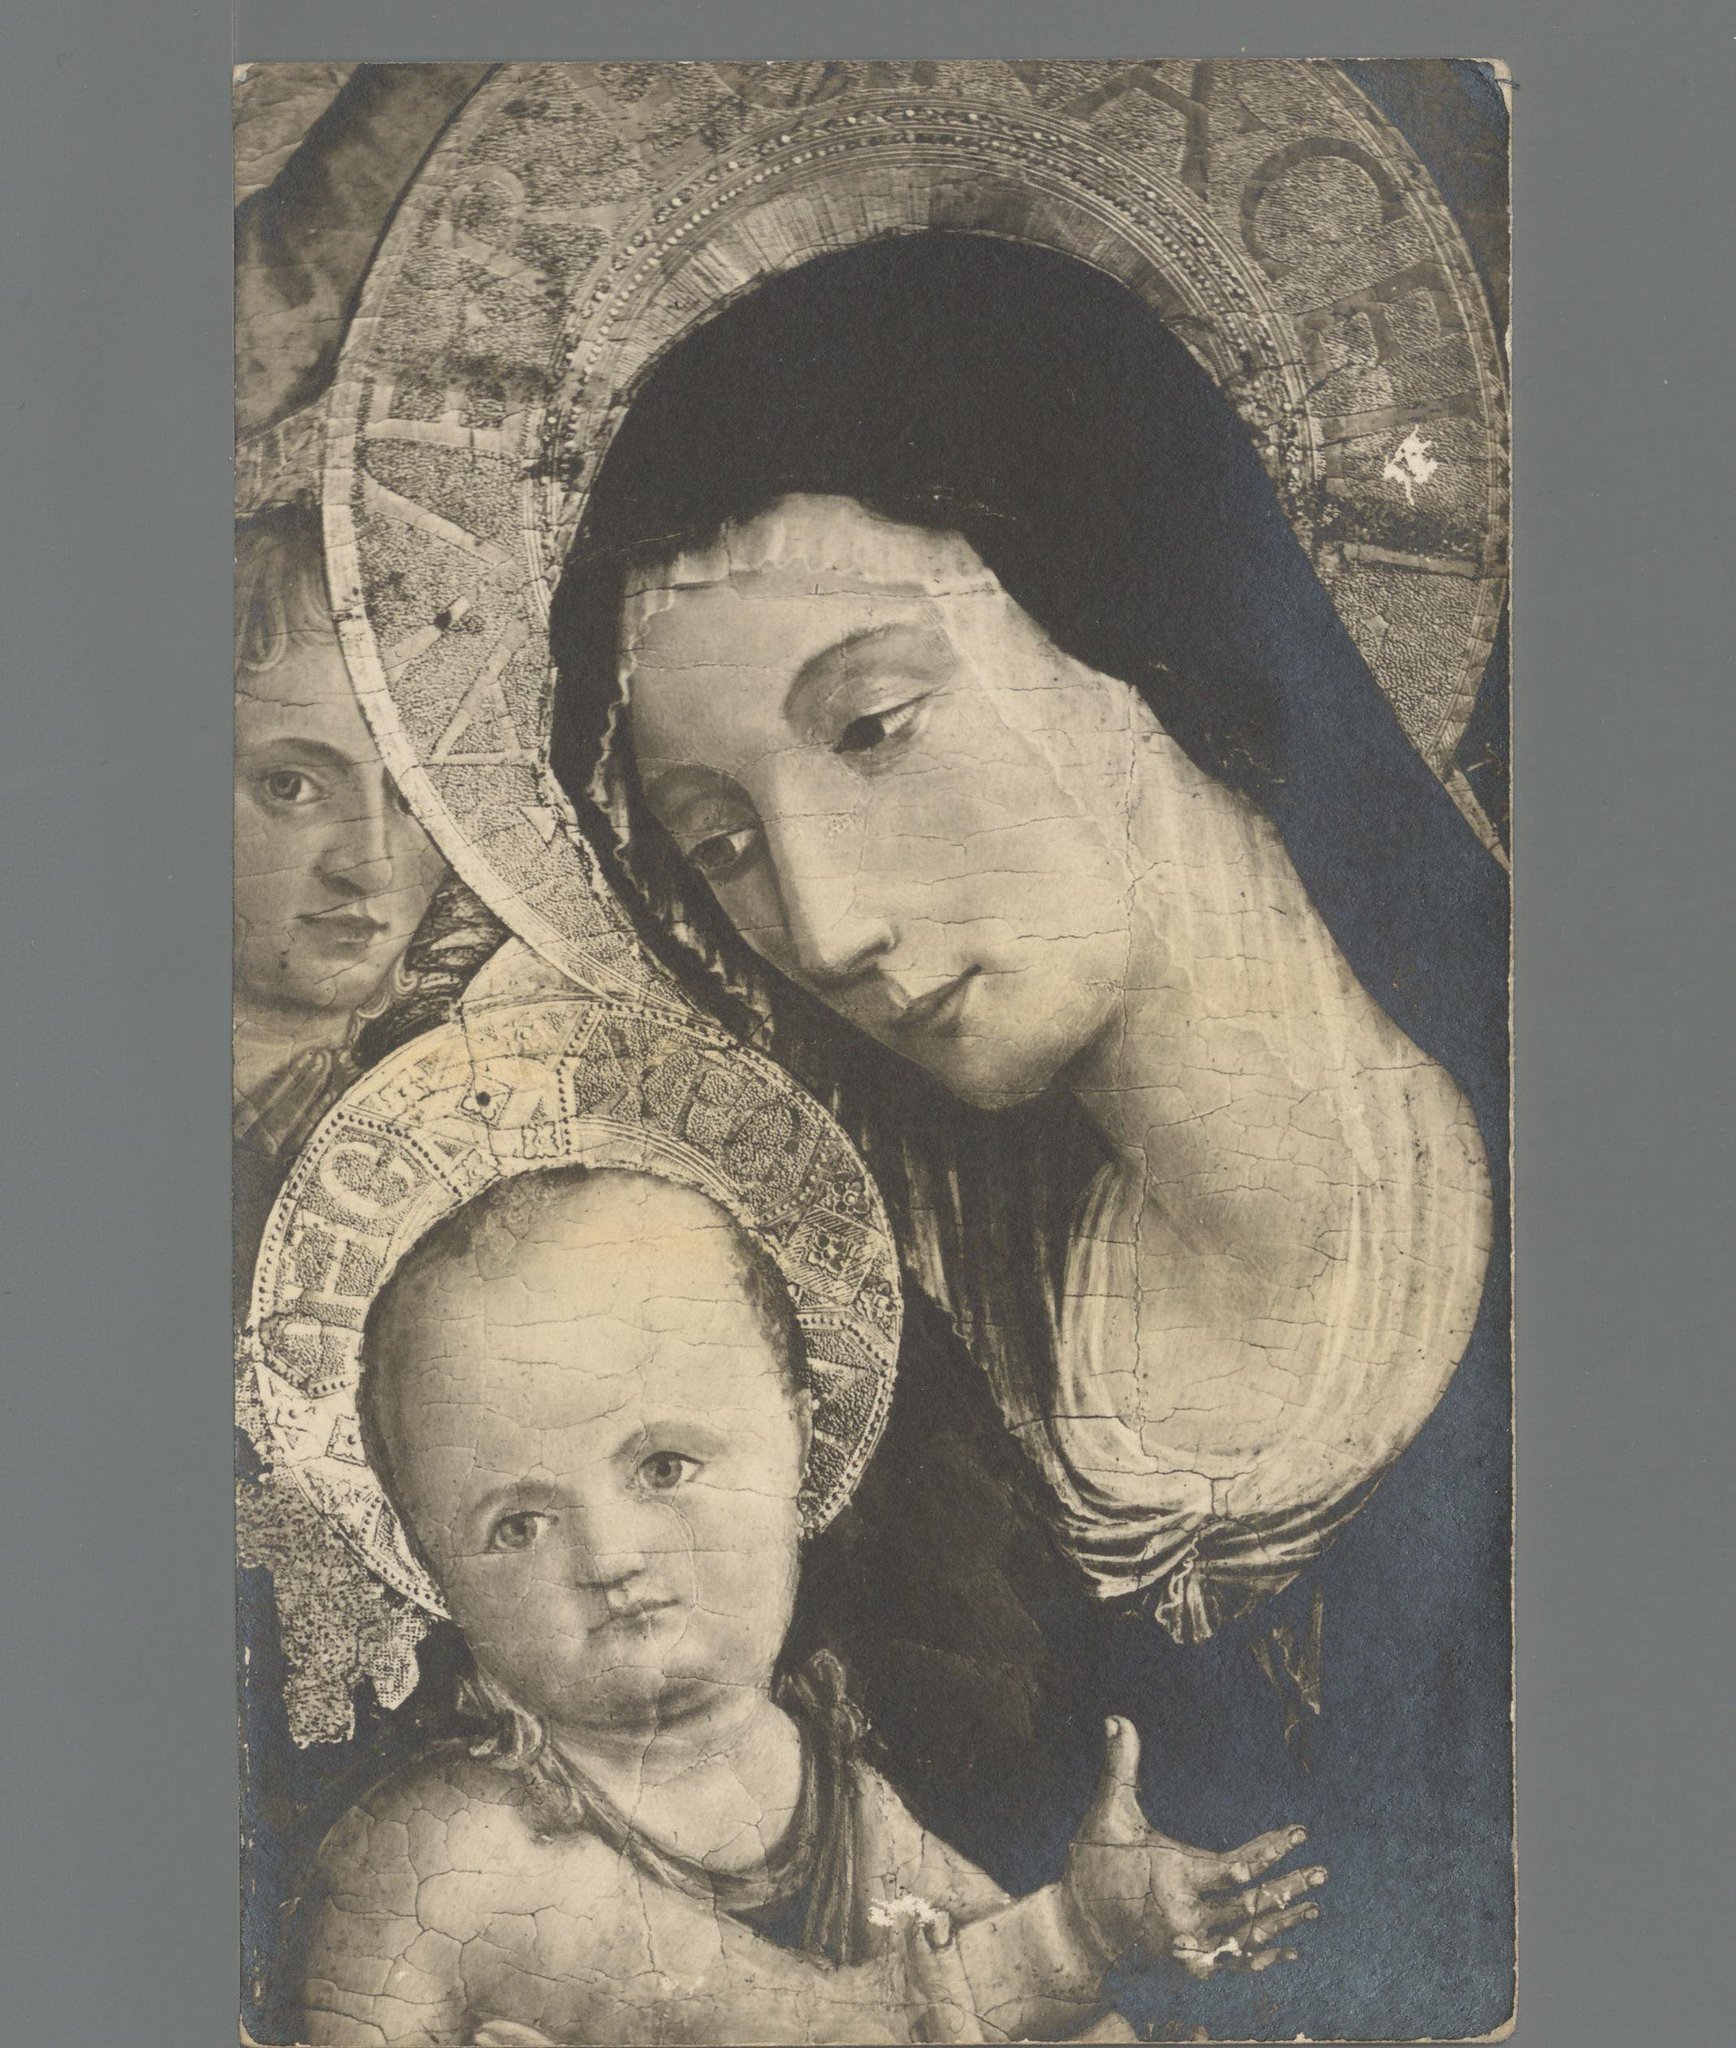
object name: ansichtkaart, prentbriefkaart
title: Detail van een schilderij van Madonna met kind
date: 1906-1930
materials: paper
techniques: gelatin silver print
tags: picture, painting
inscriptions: collector's mark: ‘AFE v S’